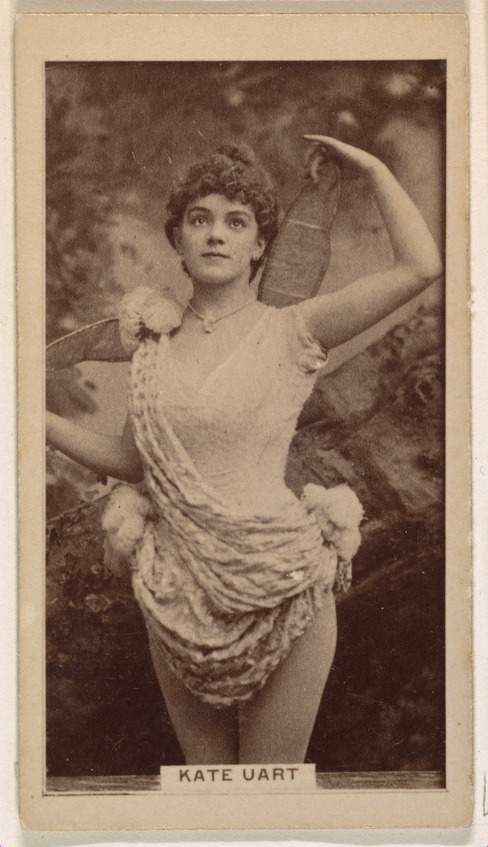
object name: photograph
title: Kate Uart, from the Actresses series (N245) issued by Kinney Brothers to promote Sweet Caporal Cigarettes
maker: kinney brothers tobacco company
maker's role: publisher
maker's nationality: american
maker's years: 1869-2011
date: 1890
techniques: albumen silver print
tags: portraits,women,actresses